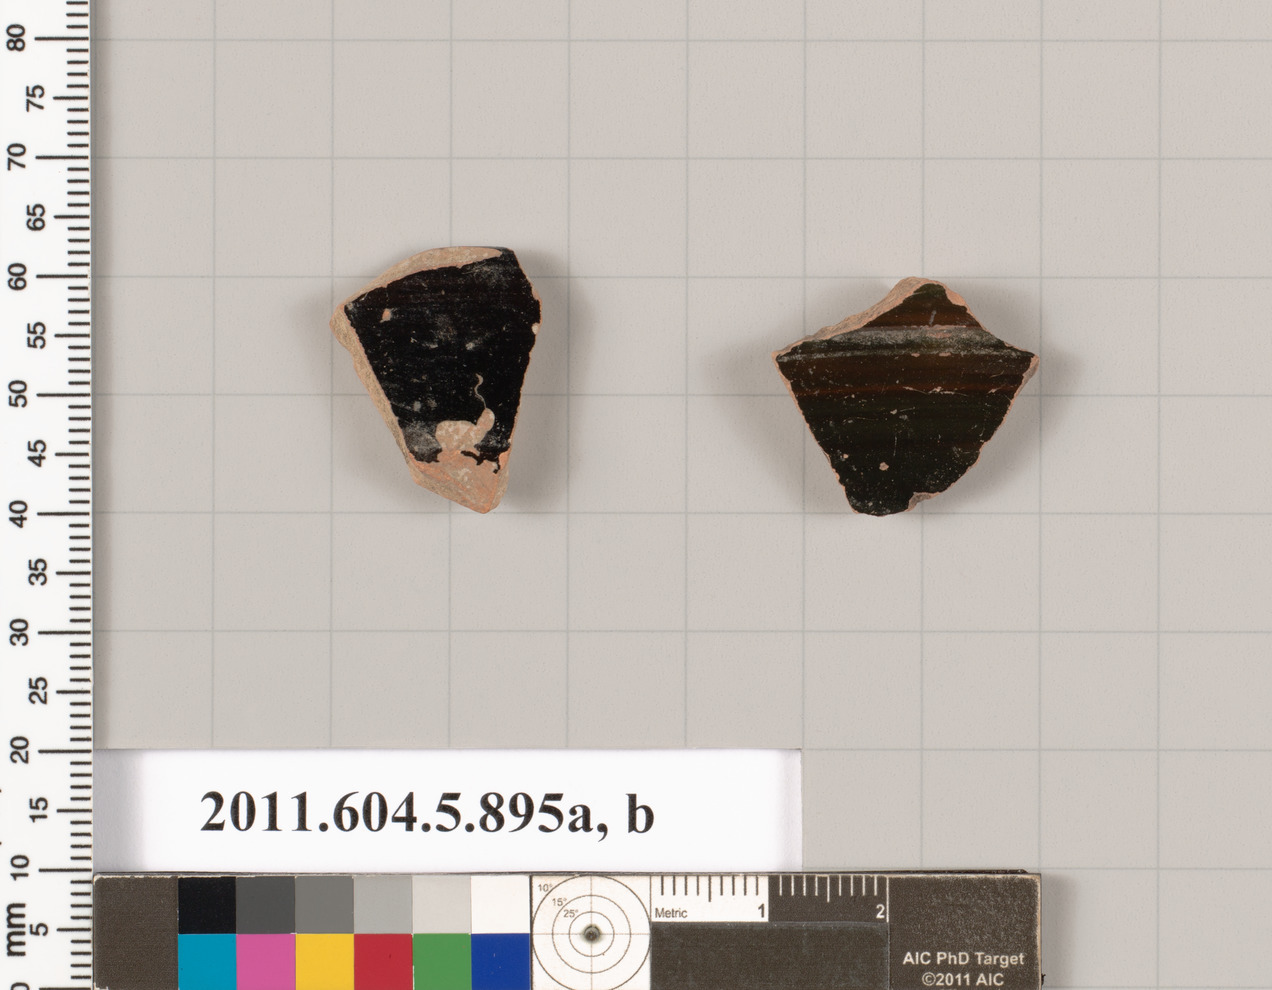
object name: kylix fragment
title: Terracotta fragments of kylikes (drinking cups)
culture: greek, attic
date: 600-401 BCE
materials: terracotta